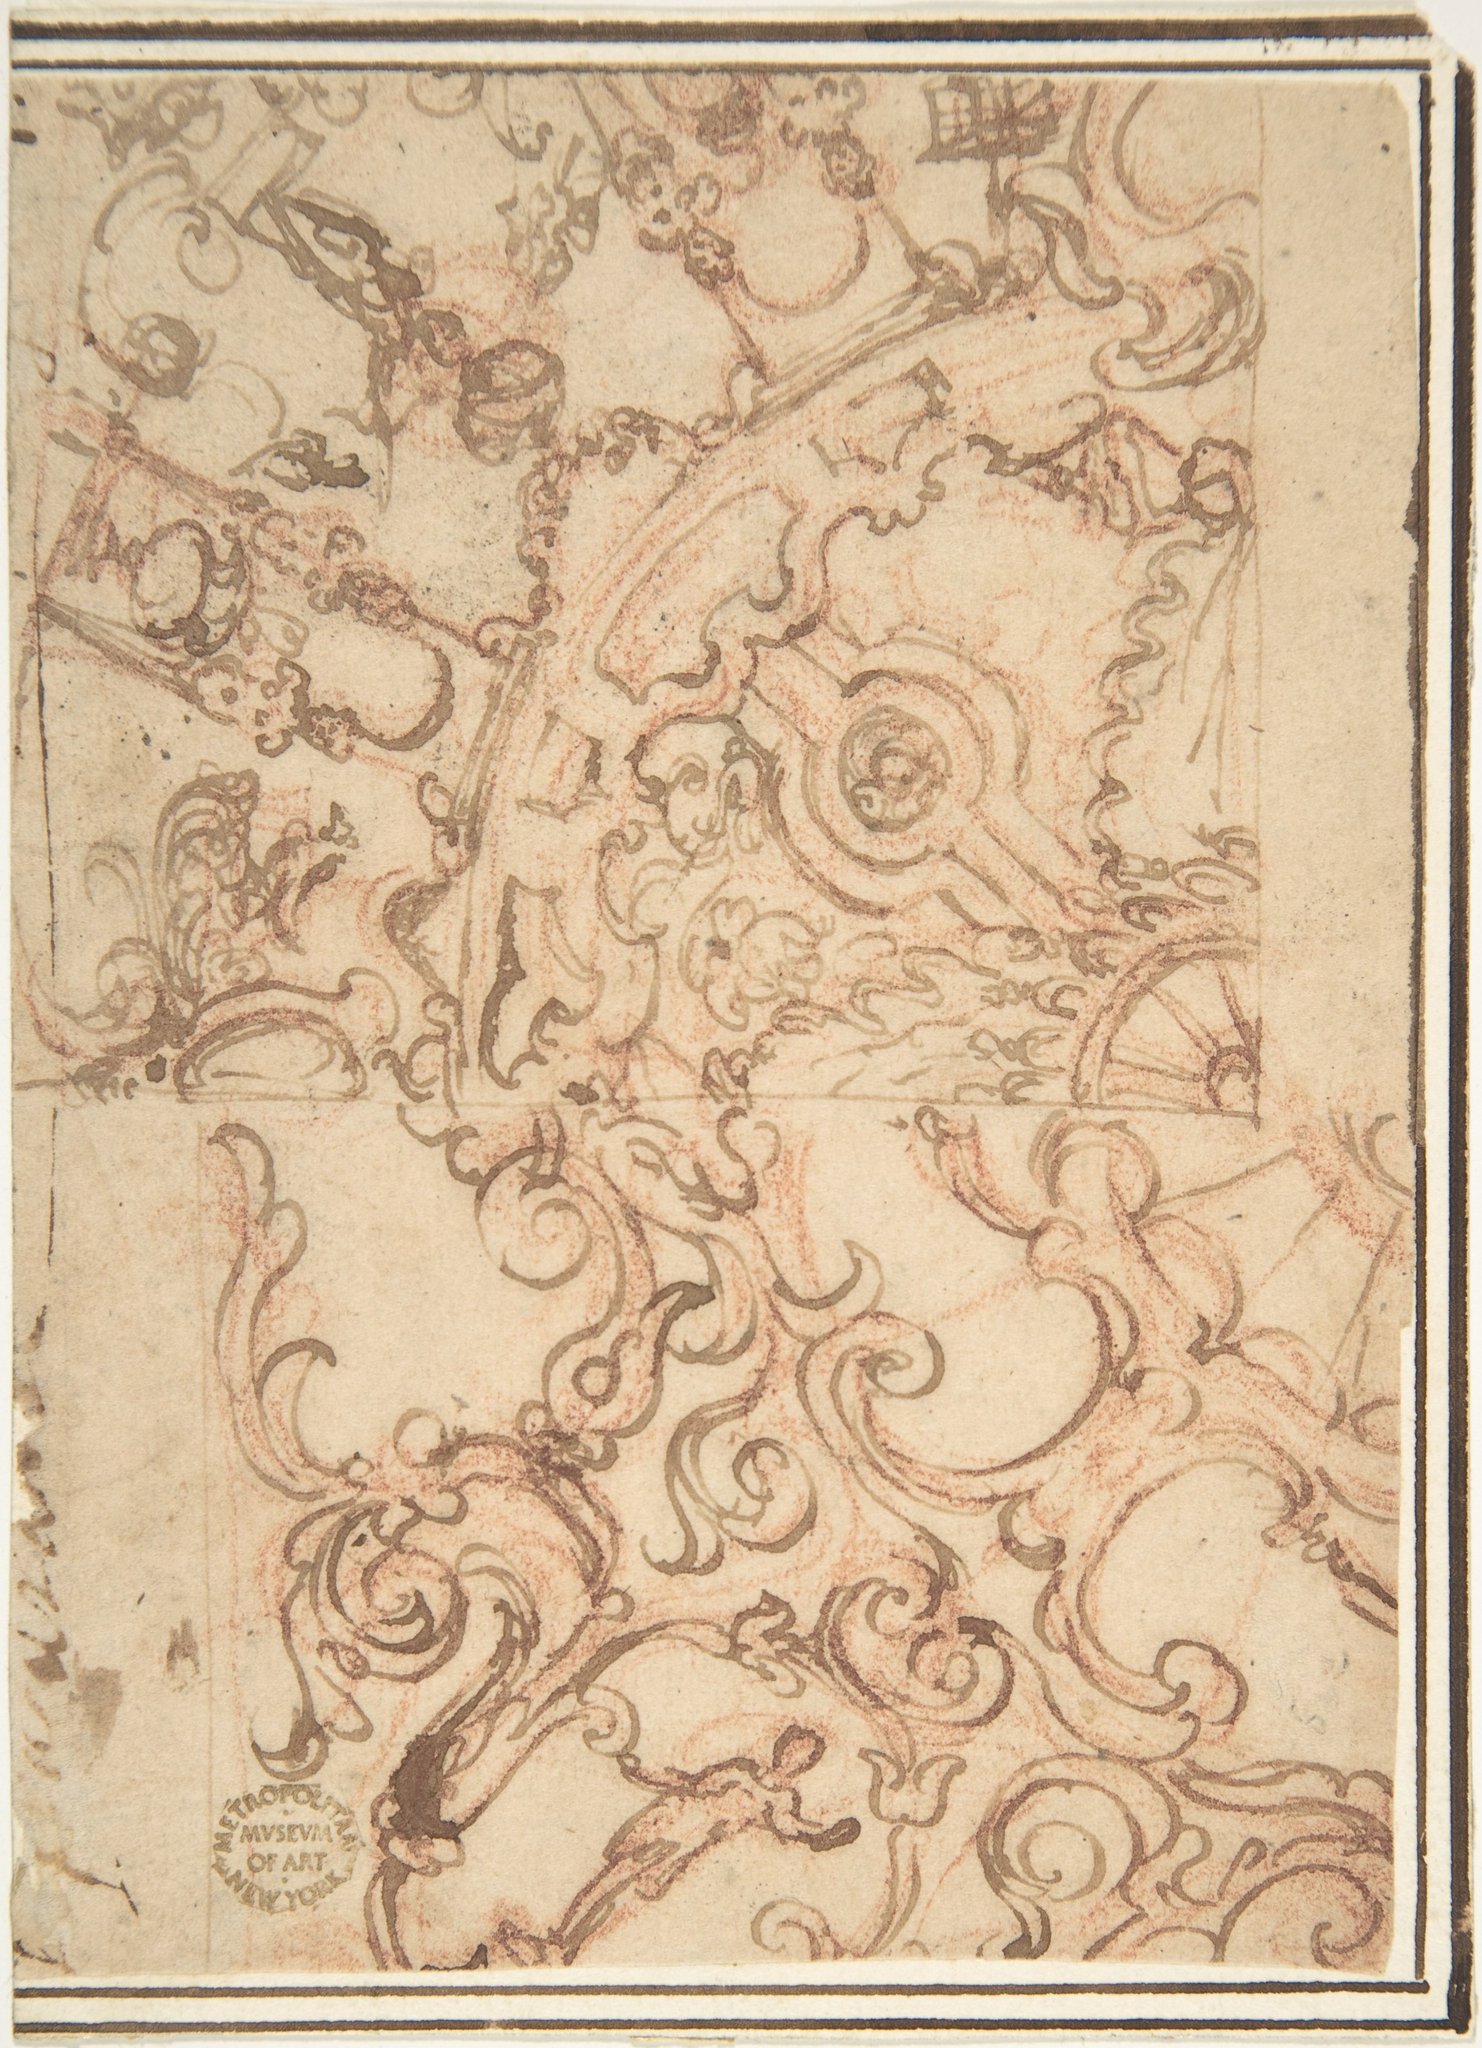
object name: drawing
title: Ceiling Decoration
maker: anonymous, italian, 16th century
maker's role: artist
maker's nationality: italian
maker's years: 1550-1600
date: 1501-1600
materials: chalk, ink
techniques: pen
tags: ornament